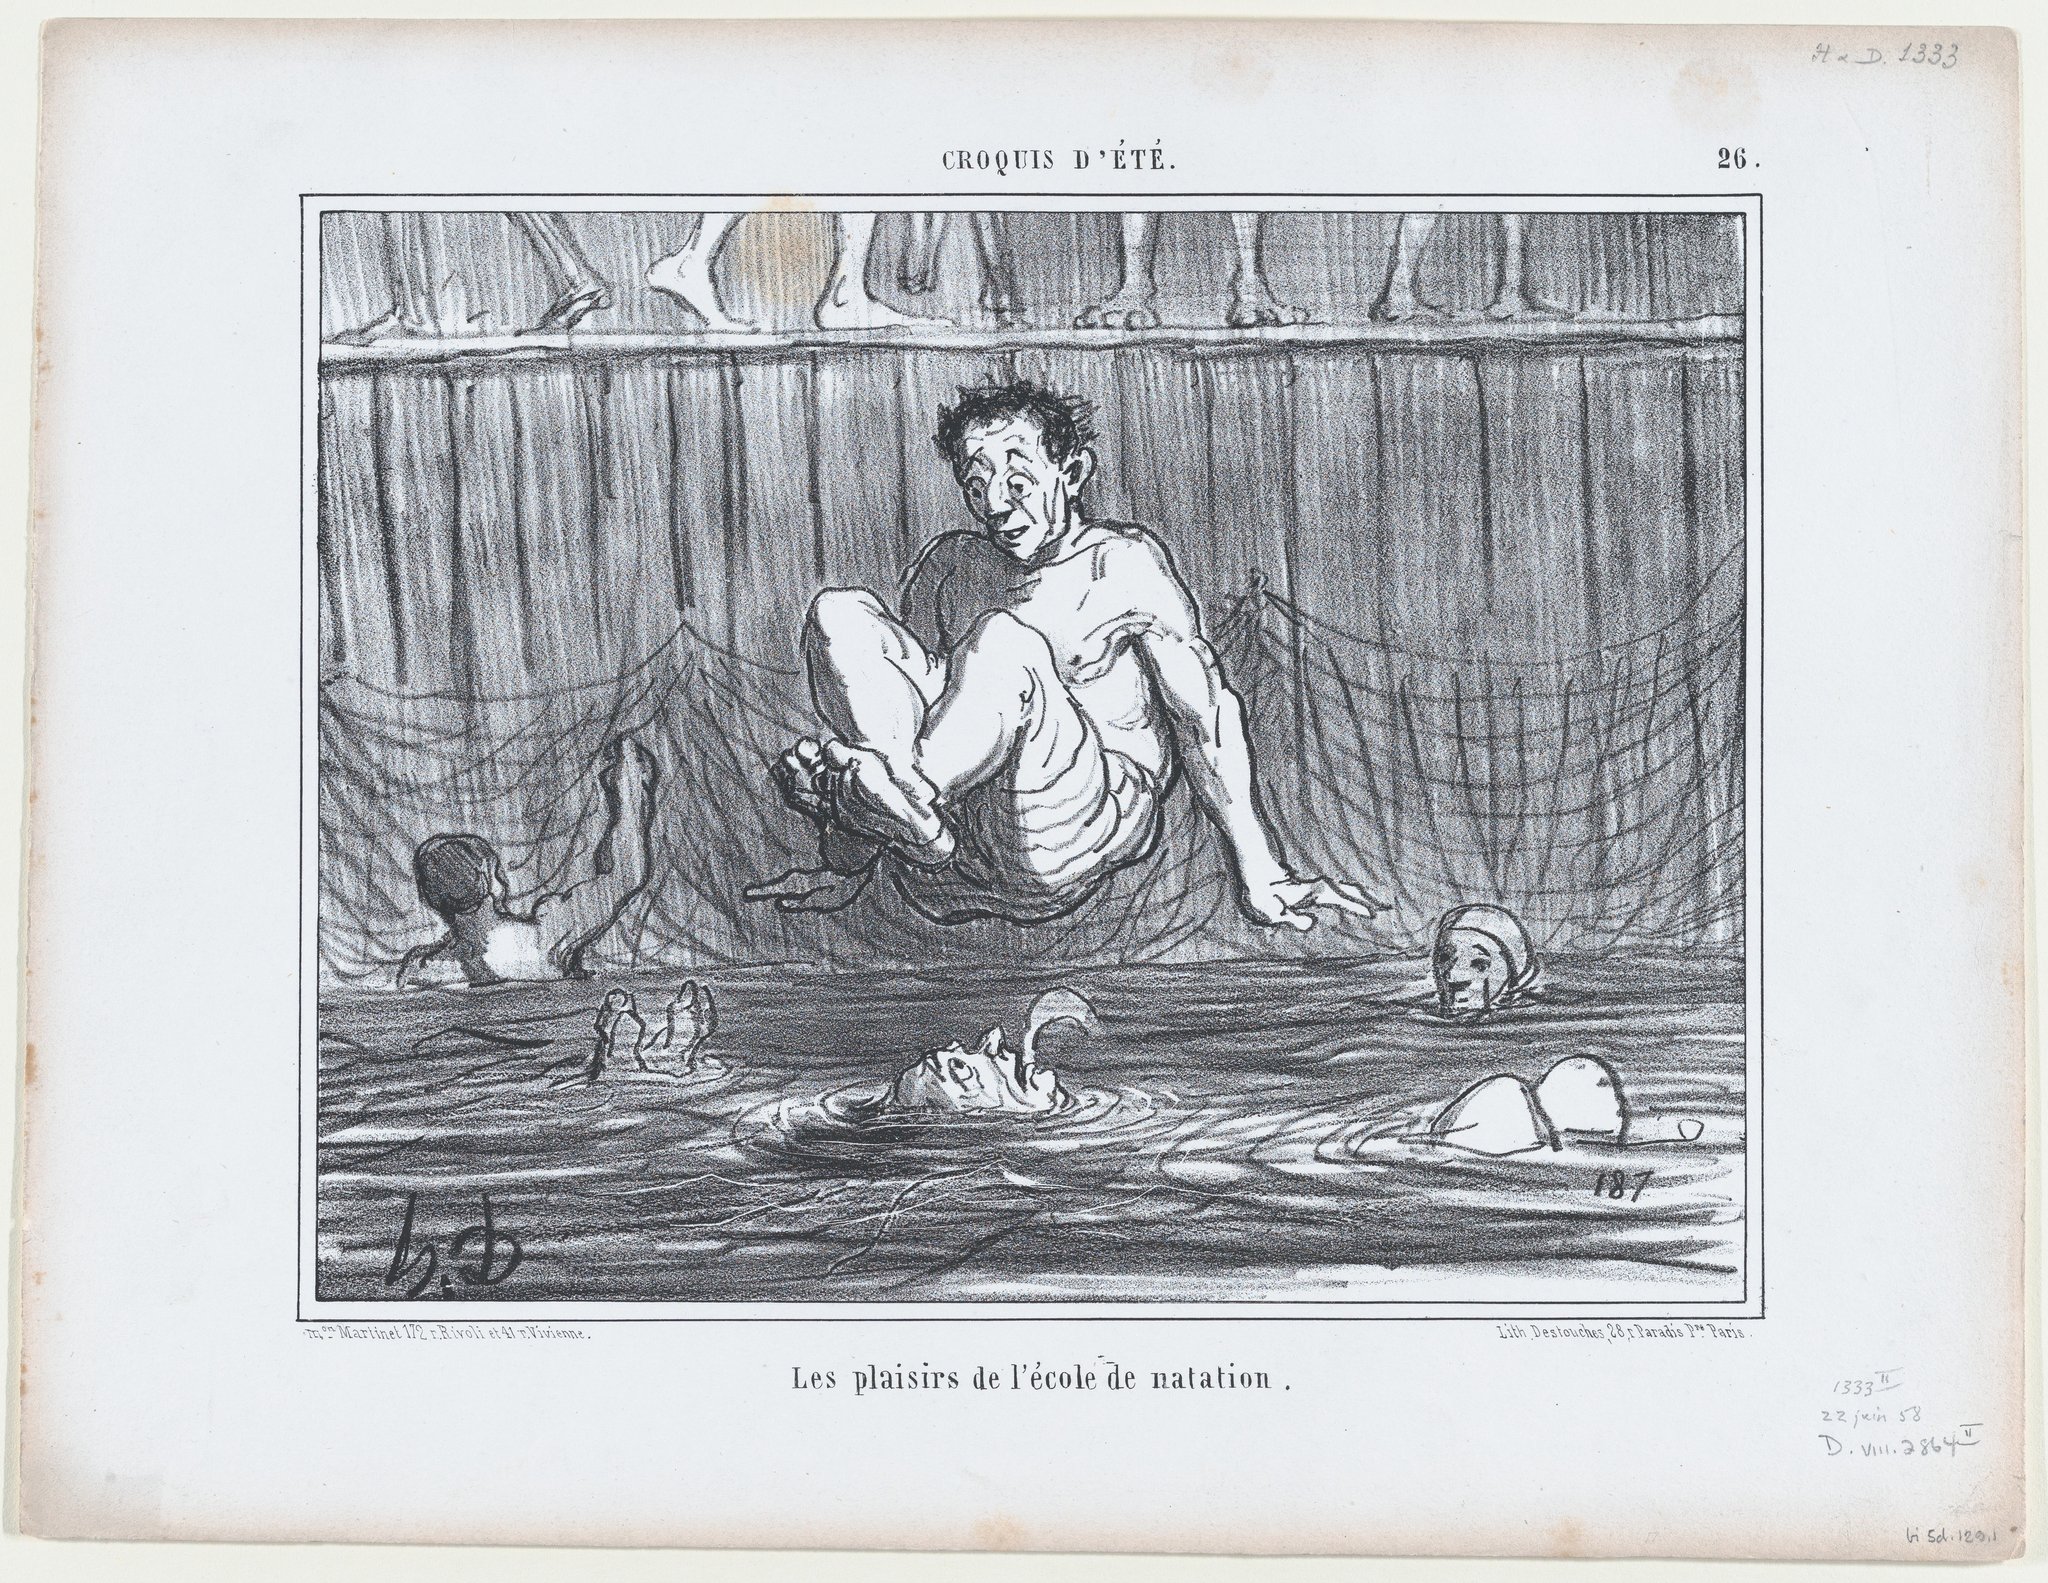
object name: print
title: Les plaisirs de l'école de natation, from Croquis Été, published in Le Charivari, June 22, 1858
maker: honoré daumier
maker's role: artist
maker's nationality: french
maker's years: 1808-1879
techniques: lithograph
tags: men,swimming,summer